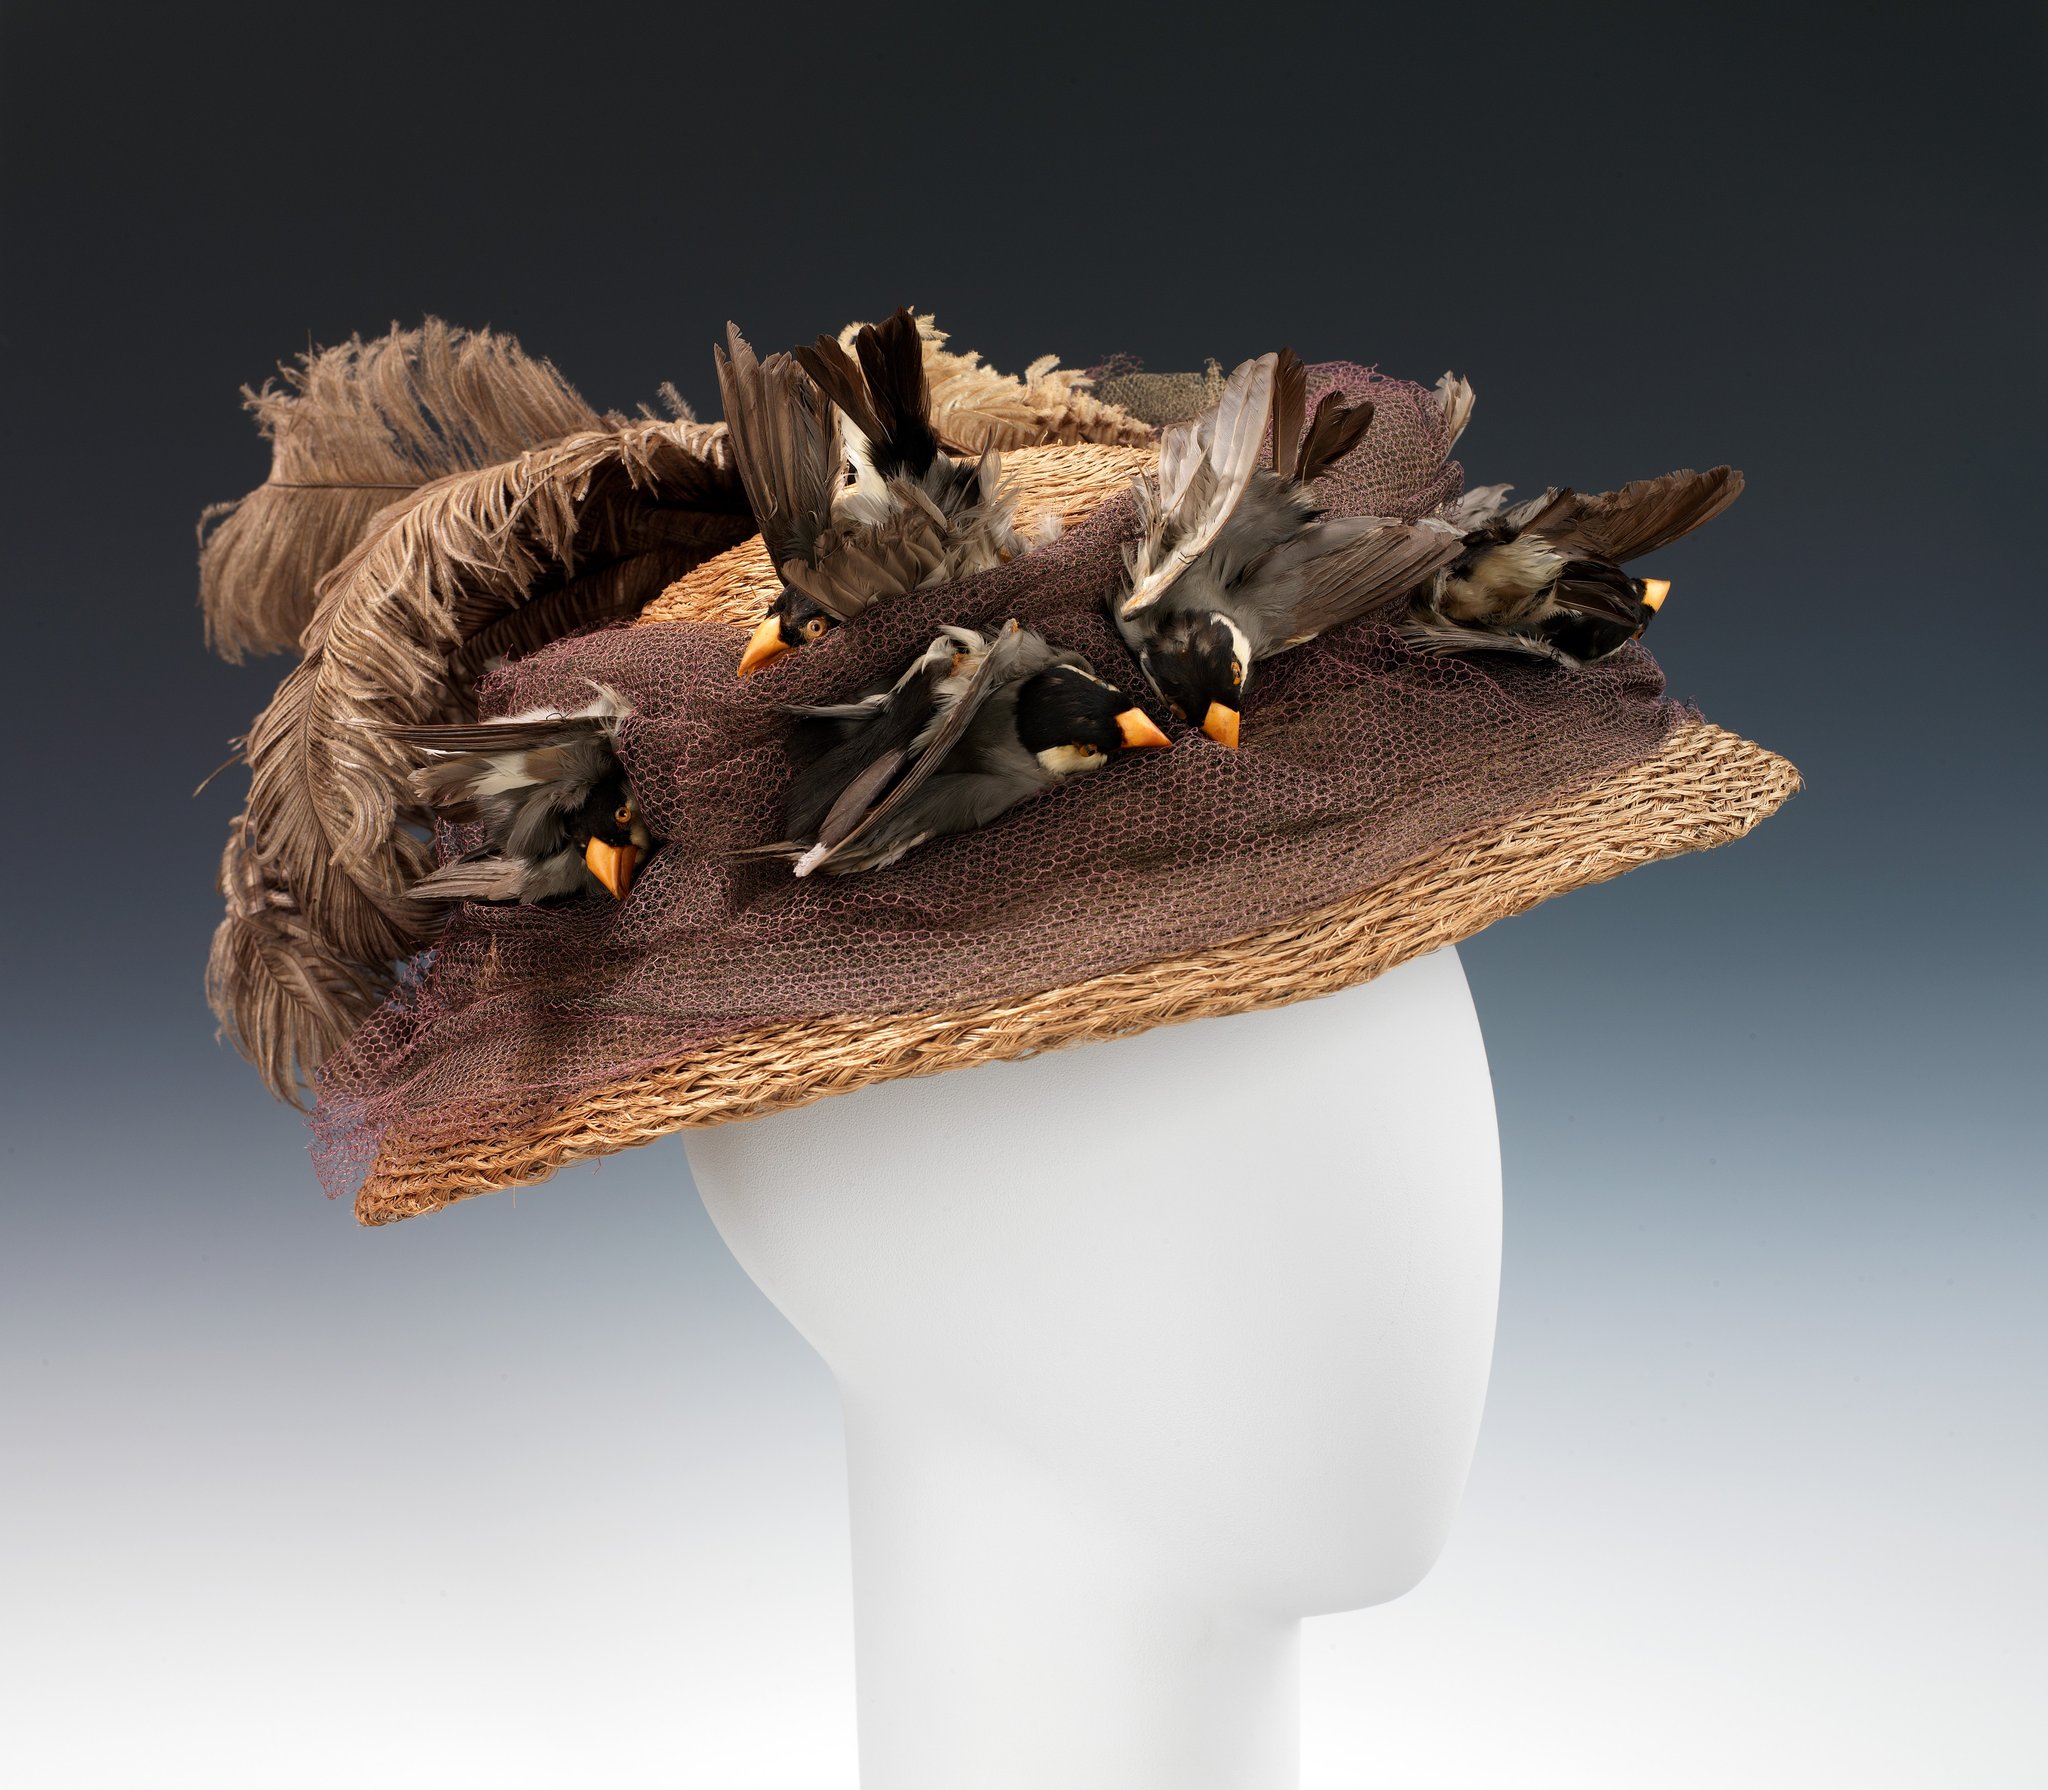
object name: hat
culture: american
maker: mlle. louise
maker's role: designer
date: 1890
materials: cotton, feather, fiber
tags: birds